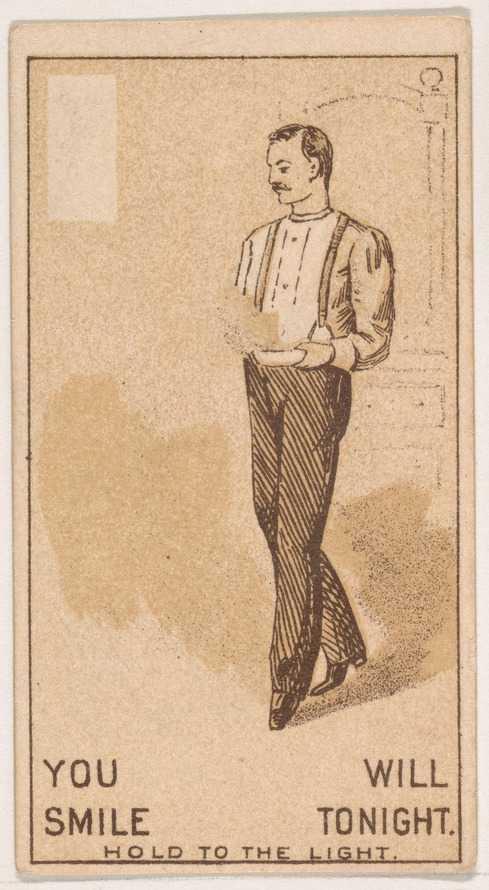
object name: print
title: You Will Smile Tonight, from the Magic Changing Cards series (N223) issued by Kinney Tobacco Company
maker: kinney brothers tobacco company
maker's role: publisher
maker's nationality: american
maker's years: 1869-2011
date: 1889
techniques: color lithograph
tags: men,profiles